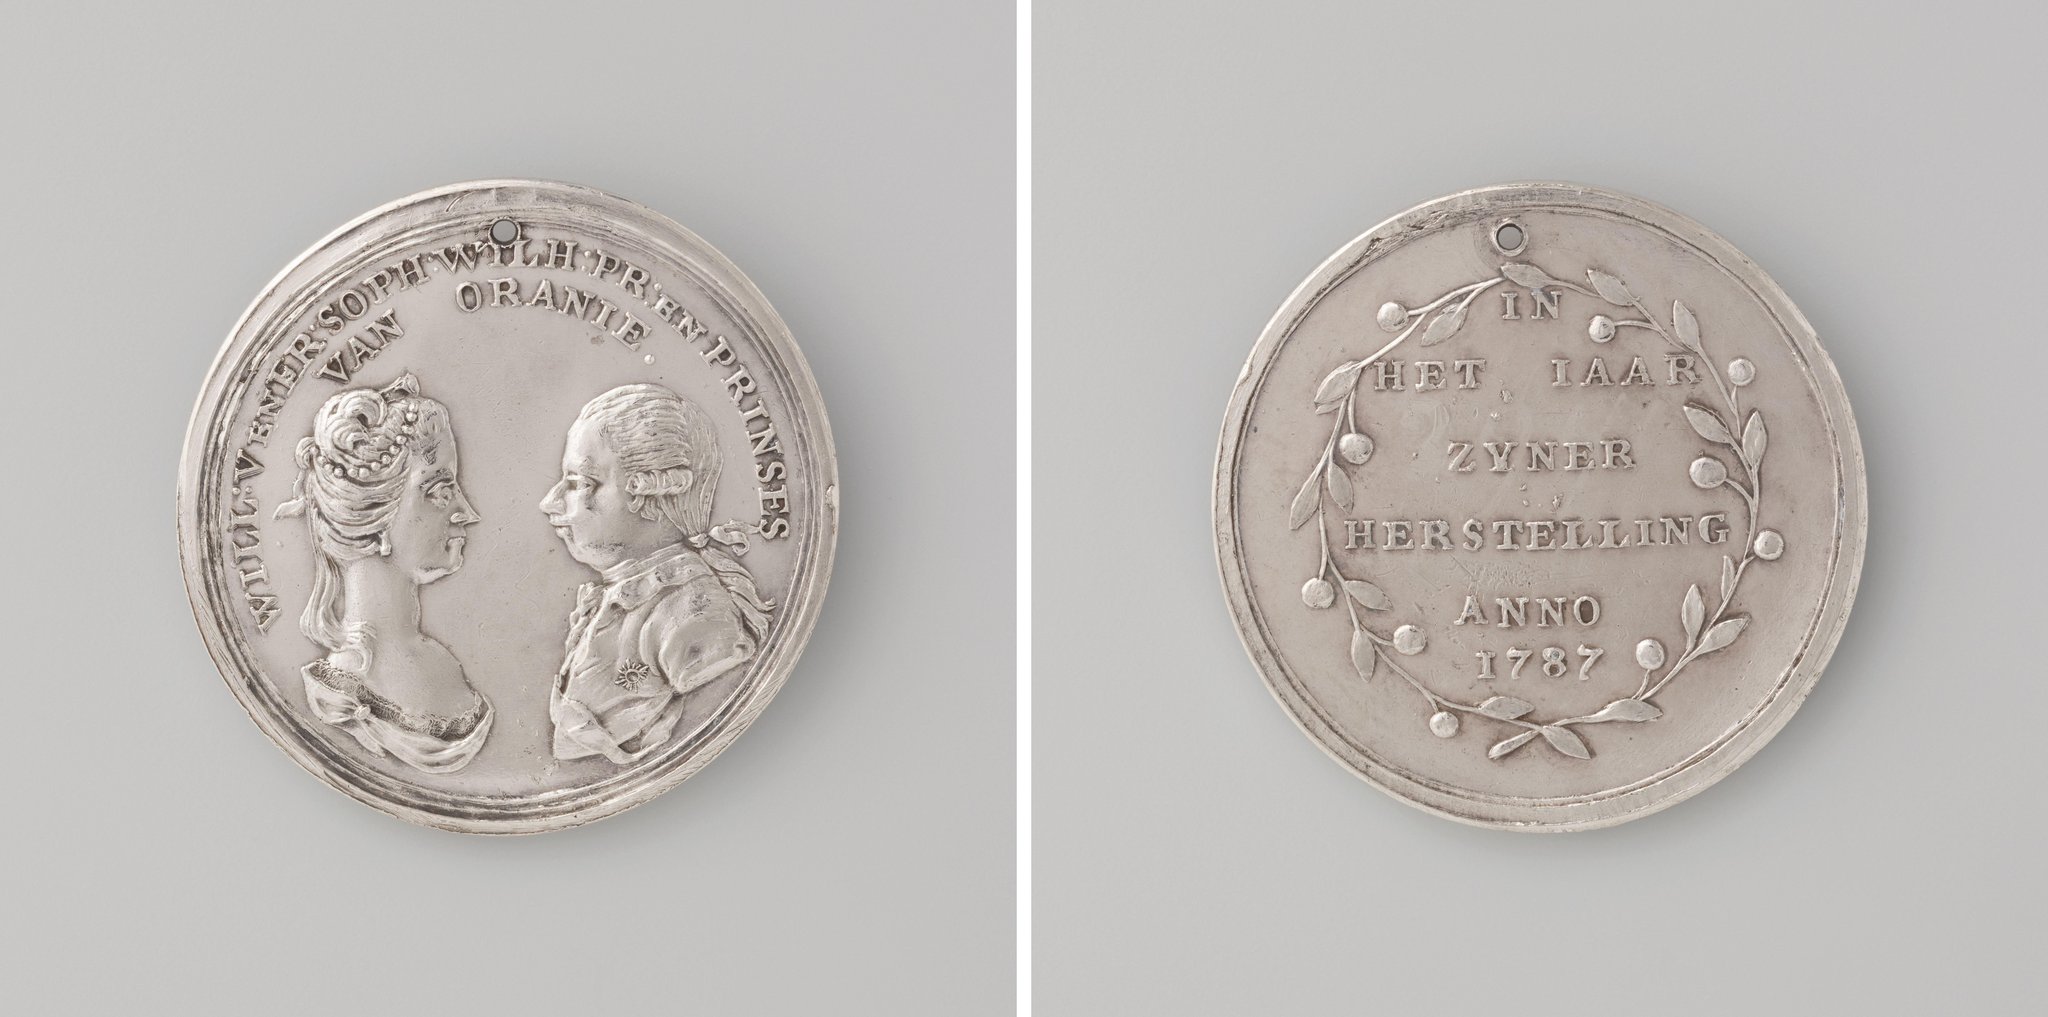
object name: history medal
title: Herstel van Willem V als erfstadhouder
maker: Anonymous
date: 1787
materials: silver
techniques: striking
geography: netherlands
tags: the hague, william v (prince of orange), berlin, draughtsman, wilhelmina of prussia (princess of orange)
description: Zilveren penning met gat erin. Voorzijde: naar elkaar gewende borststukken van man en vrouw binnen omschrift. Keerzijde: opschrift binnen krans van oranjetakken